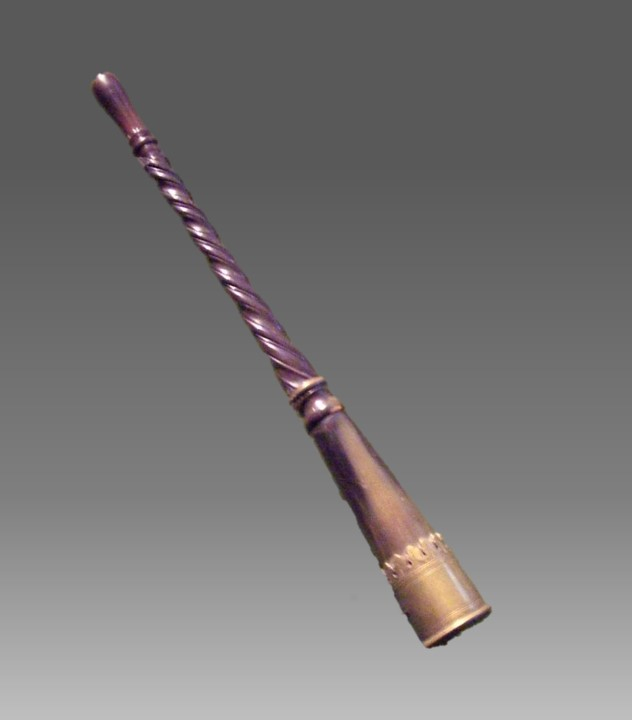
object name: falconer's horn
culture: german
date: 1501-1800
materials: brass, horn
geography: germany